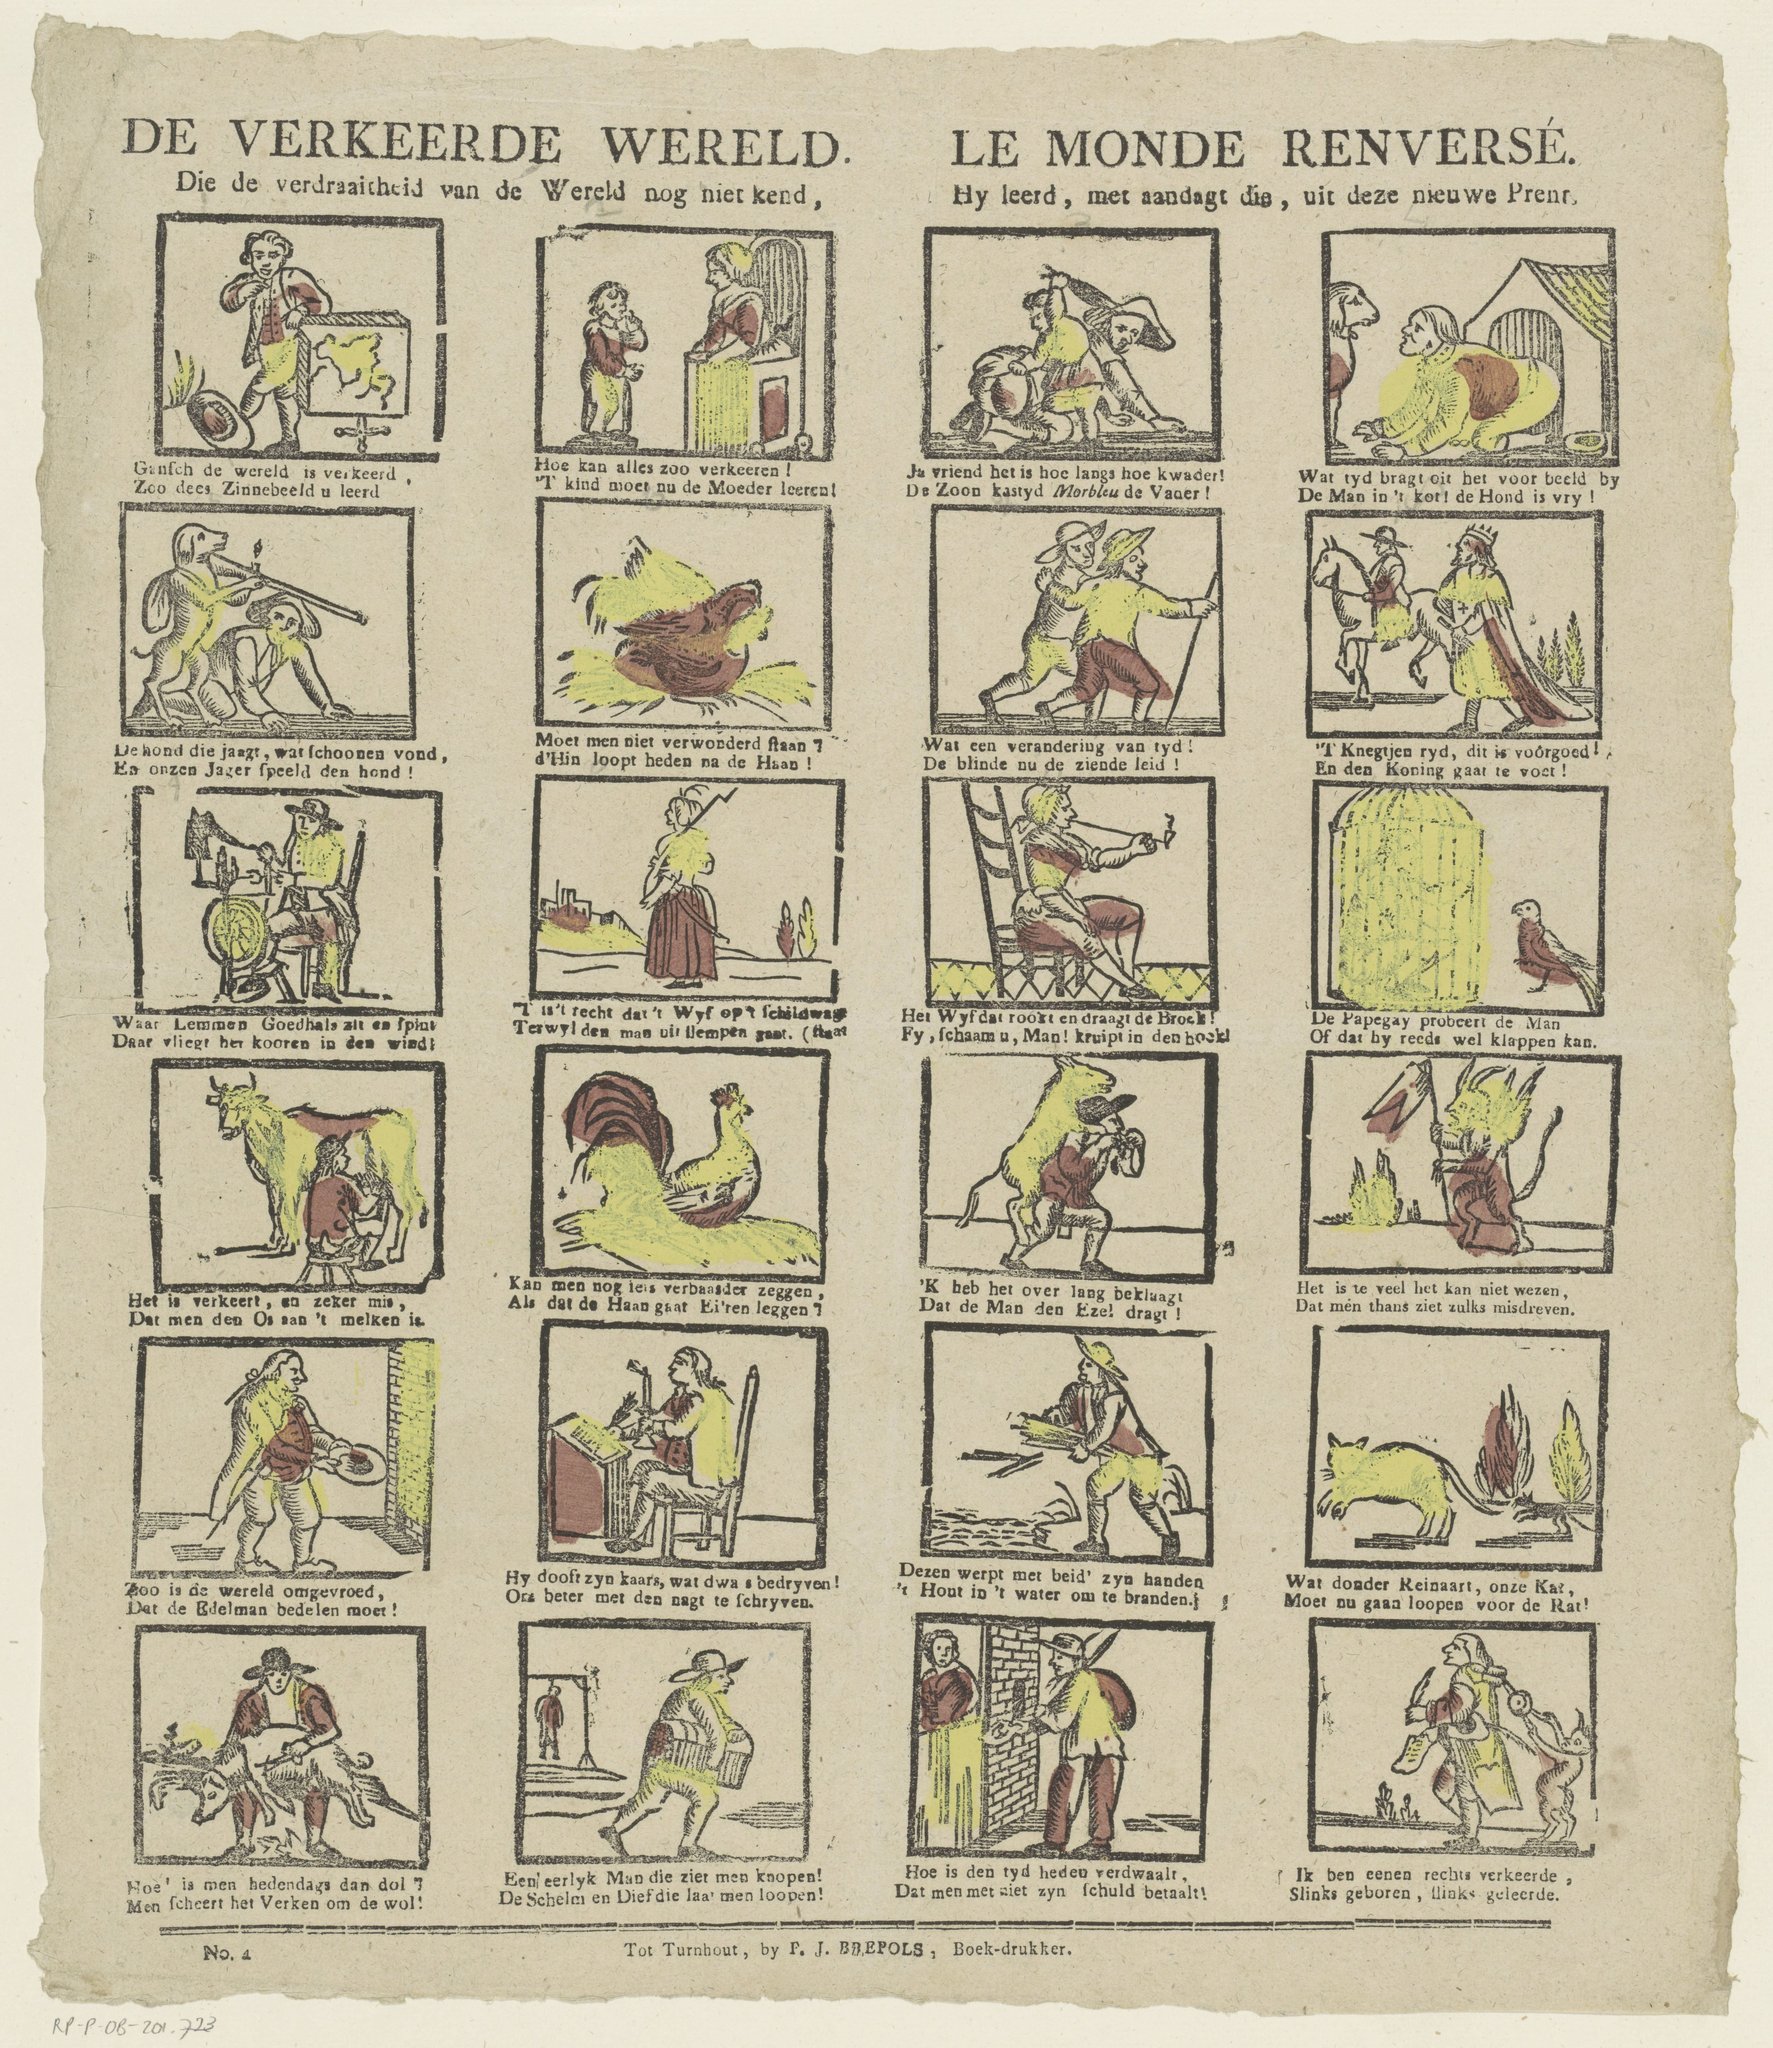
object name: print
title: De verkeerde wereld / Le monde renversé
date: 1800-1833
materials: paper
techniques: colour, letterpress printing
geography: turnhout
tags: 'mundus inversus', the reversed world, the topsy-turvy world, 'le monde bestourné', animals acting as human beings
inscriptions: collector's mark: Lugt 2760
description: Blad met 24 voorstellingen over de verkeerde wereld, waar onder andere dieren zich als mensen gedragen. Onder elke voorstelling en de titel een tweeregelig vers in het Nederlands. Genummerd linksonder: No. 4.